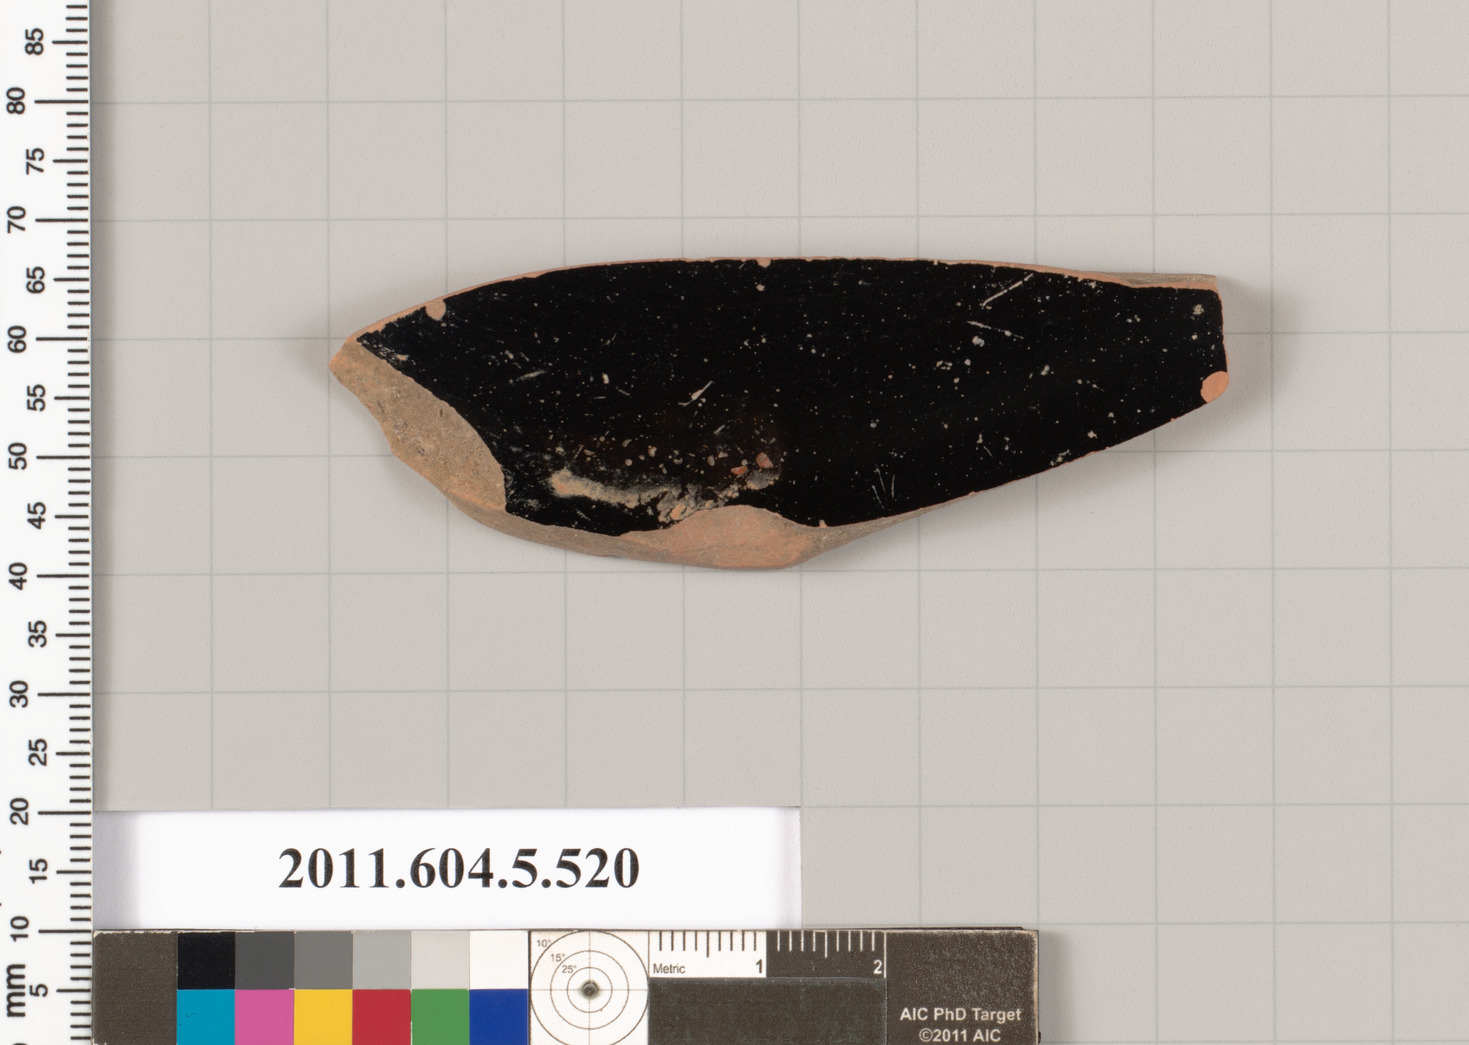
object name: kylix fragment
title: Terracotta fragment of a kylix (drinking cup)?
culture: greek, attic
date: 600-401 BCE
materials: terracotta